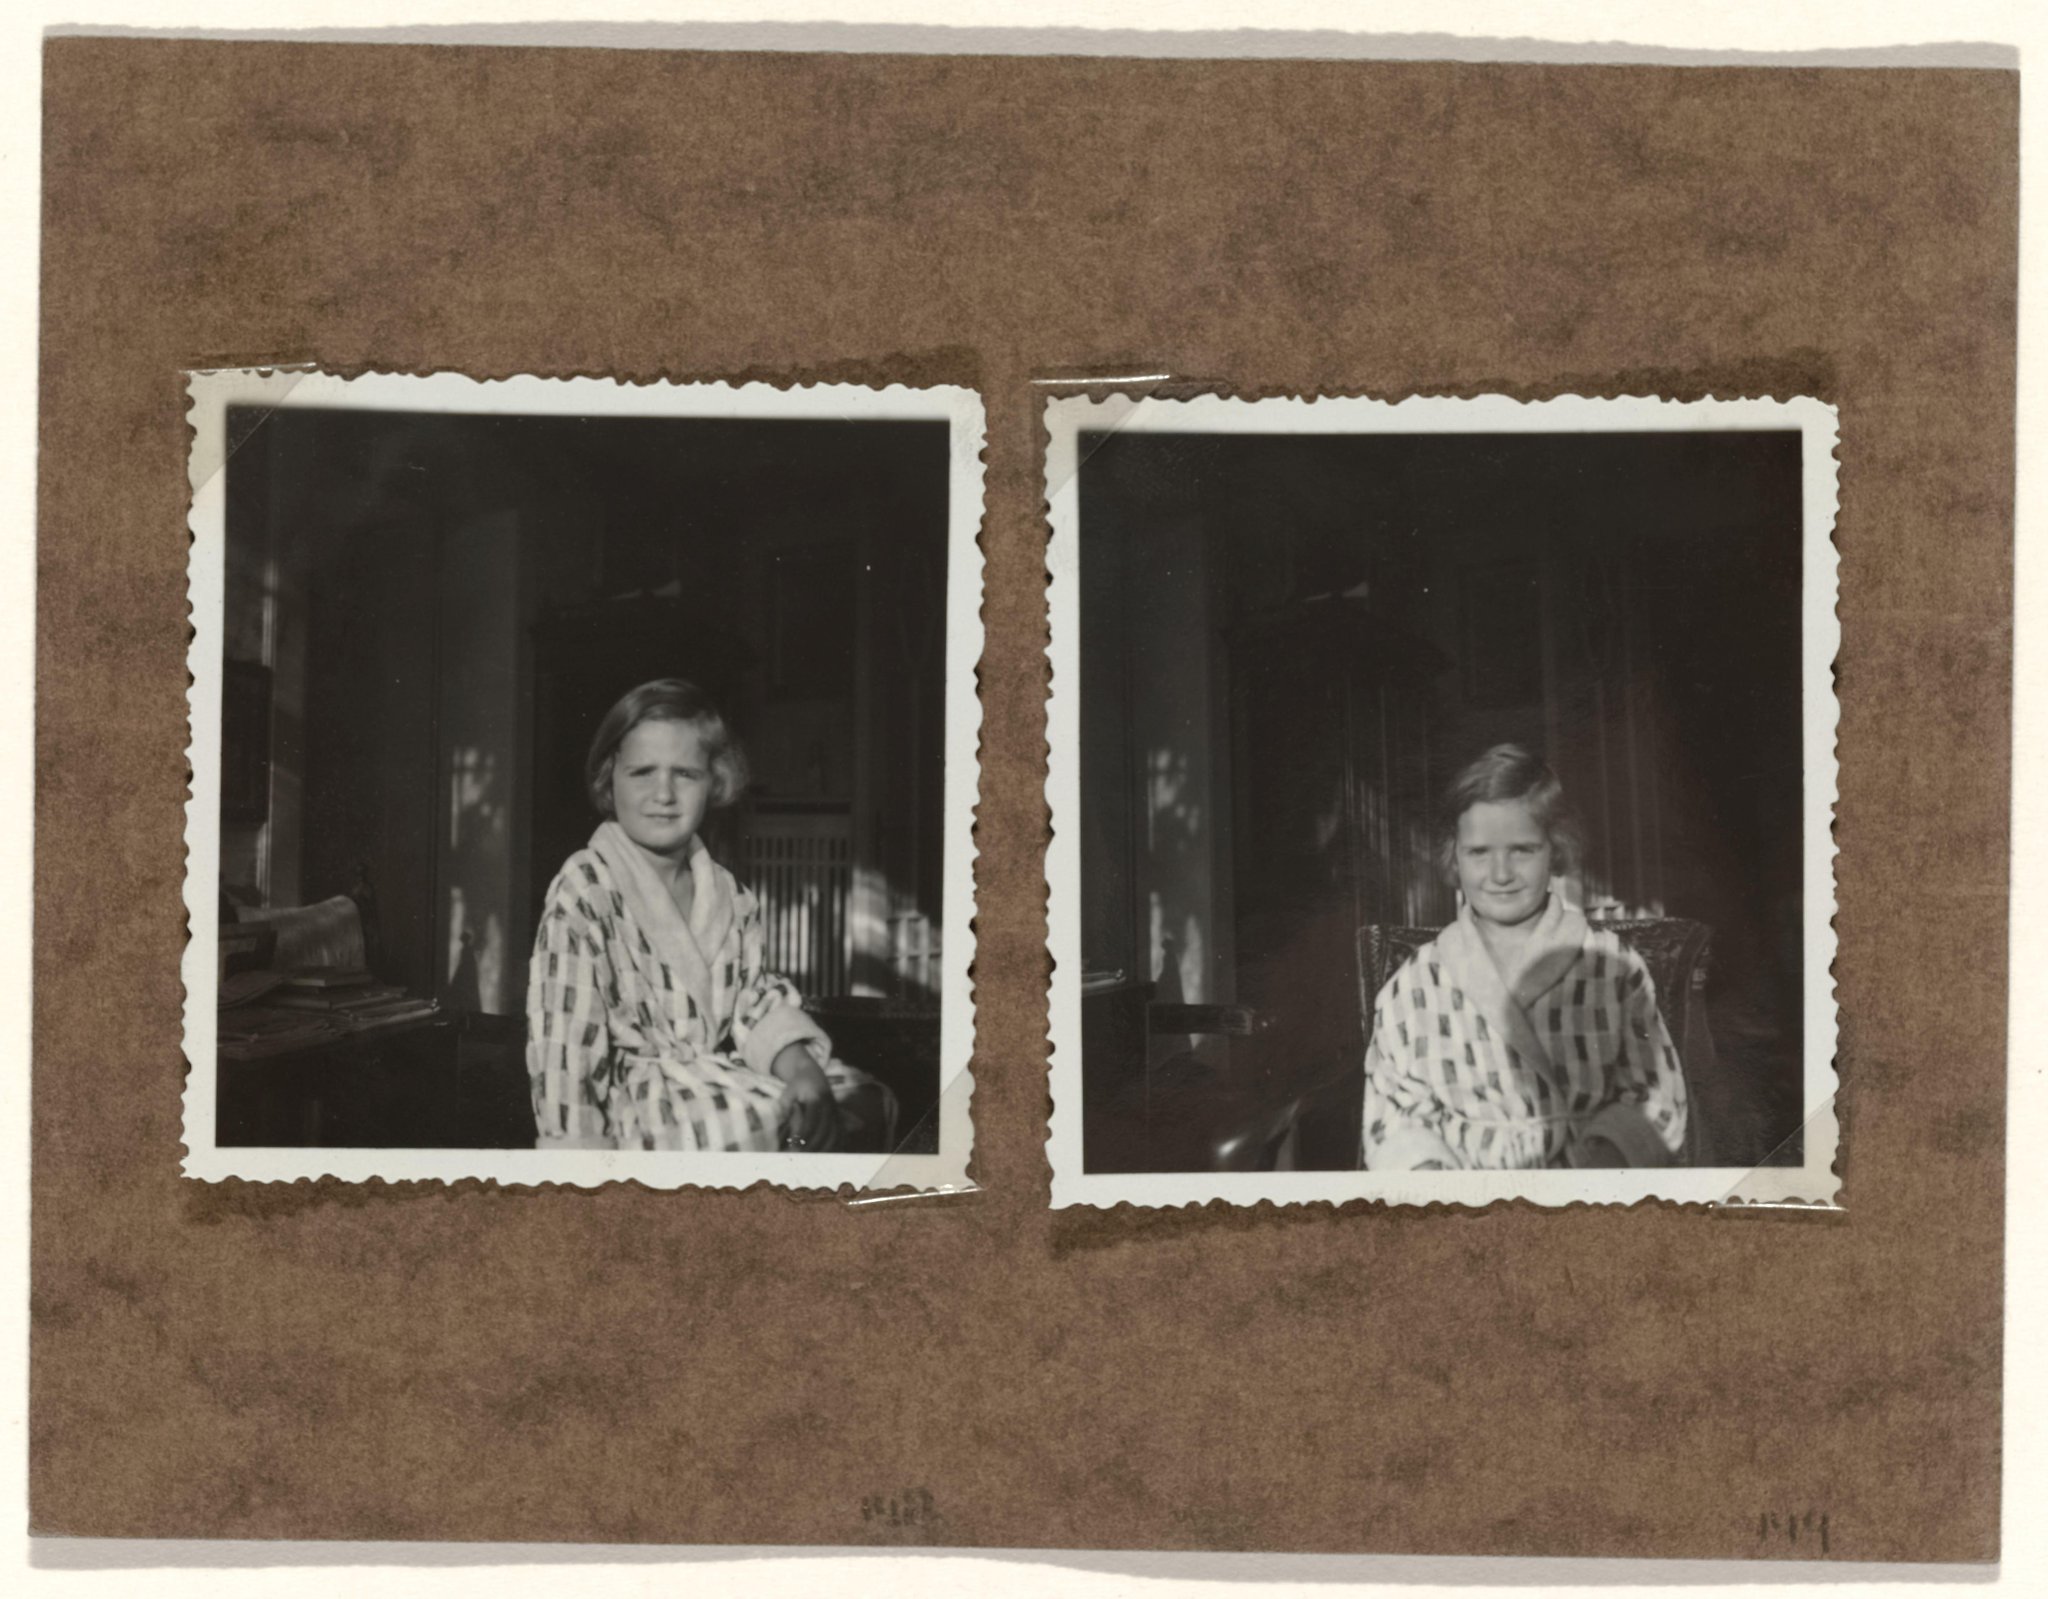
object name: photograph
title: Isabel Wachenheimer in een gestreepte ochtendjas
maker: Anonymous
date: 1931-1937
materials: photographic support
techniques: gelatin silver print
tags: isabel wachenheimer-elon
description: Isabel Wachenheimer in een gestreepte ochtendjas.